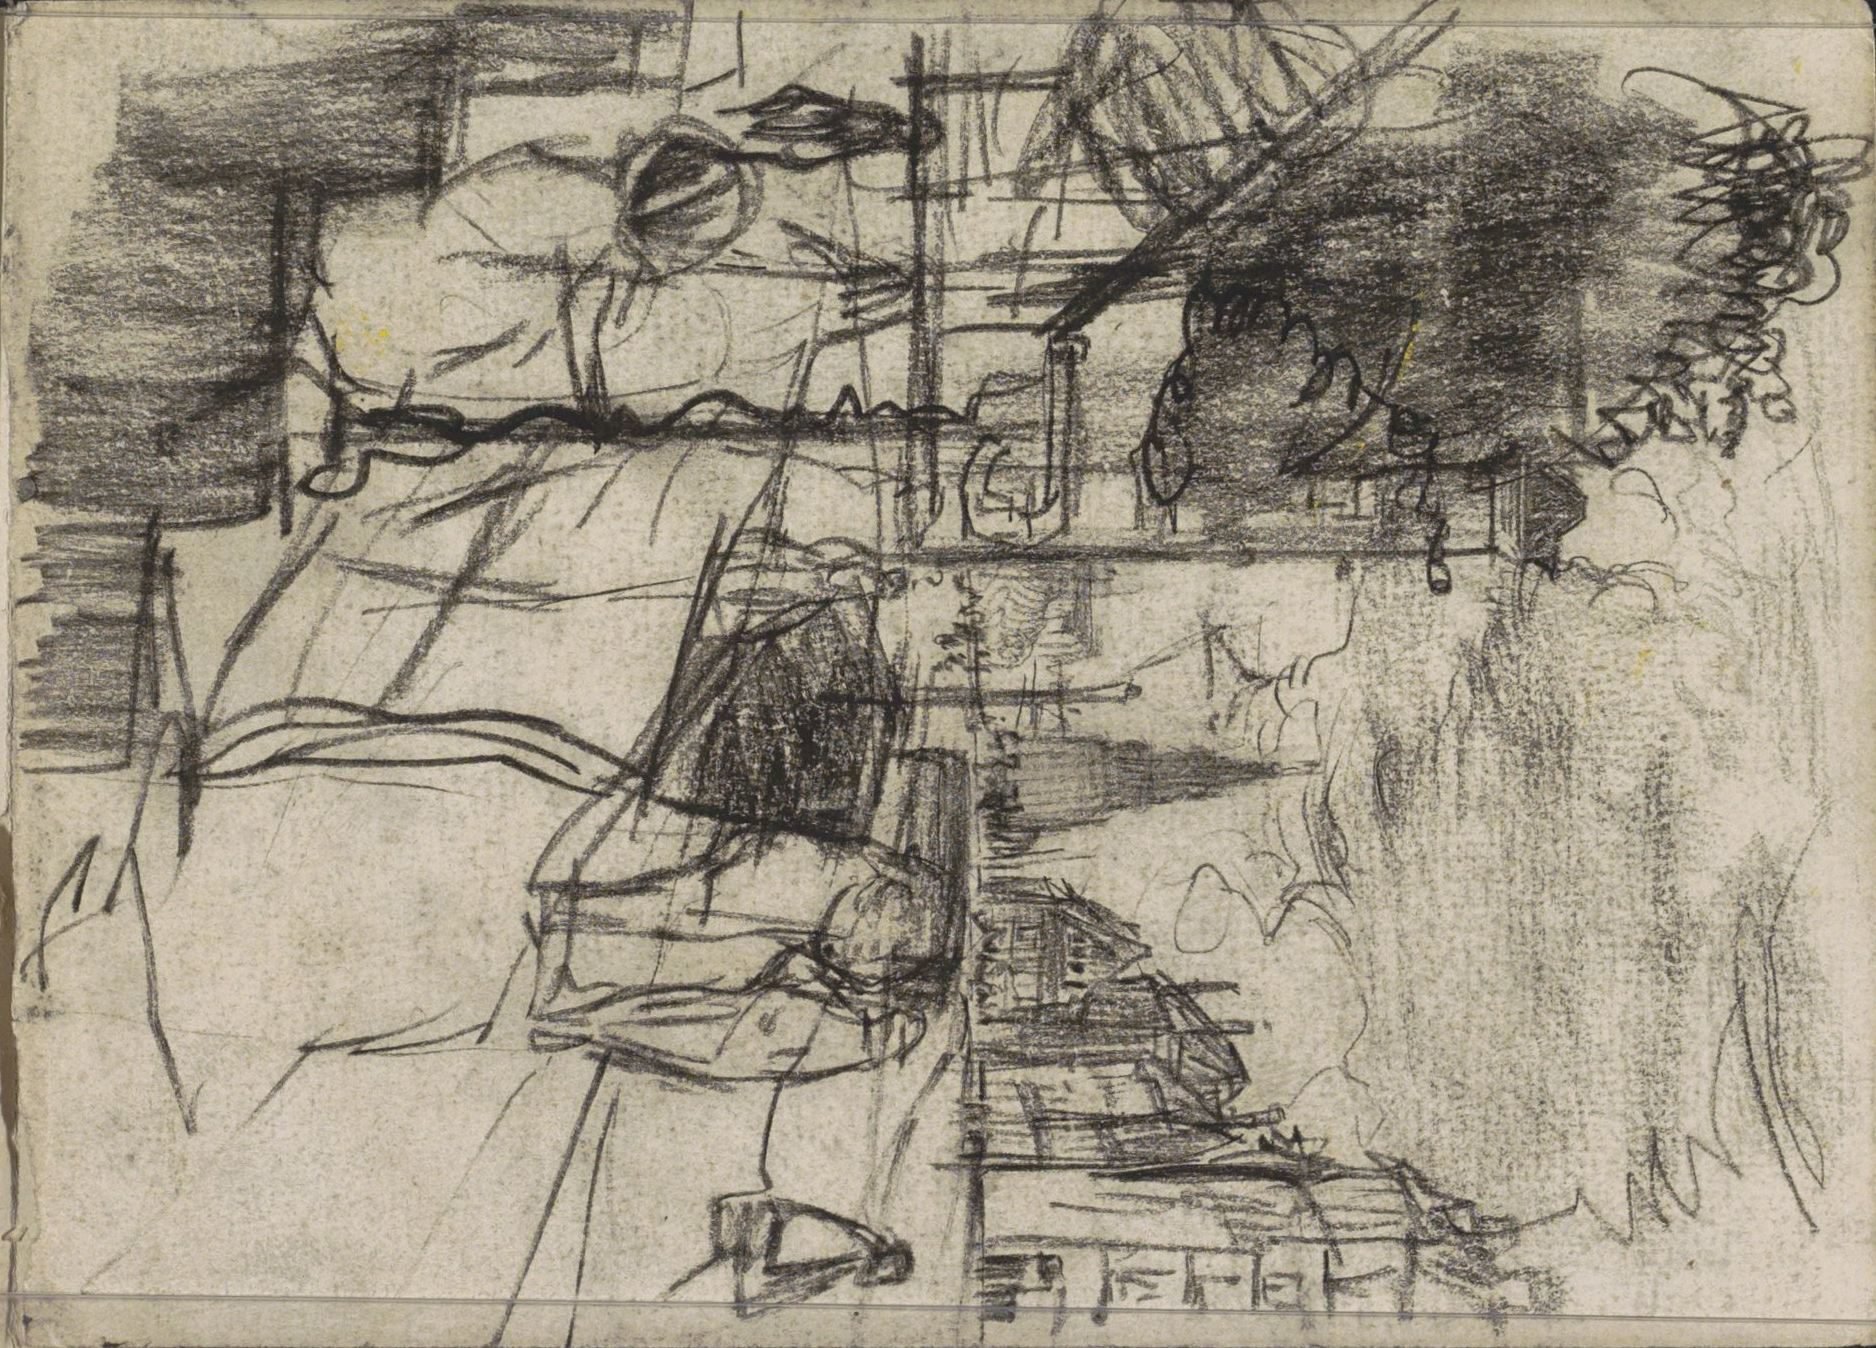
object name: drawing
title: Stadsgezicht met figuren, mogelijk in Amsterdam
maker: isaac israels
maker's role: draughtsman, painter, print maker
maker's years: 1865-1934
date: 1886-1903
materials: chalk, paper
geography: amsterdam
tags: street (+ city(-scape) with figures, staffage), amsterdam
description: Losse tekening, blad 1 recto, aangetroffen tussen pagina 50 en het achterste schutblad in schetsboek XLVII met 52 pagina's.